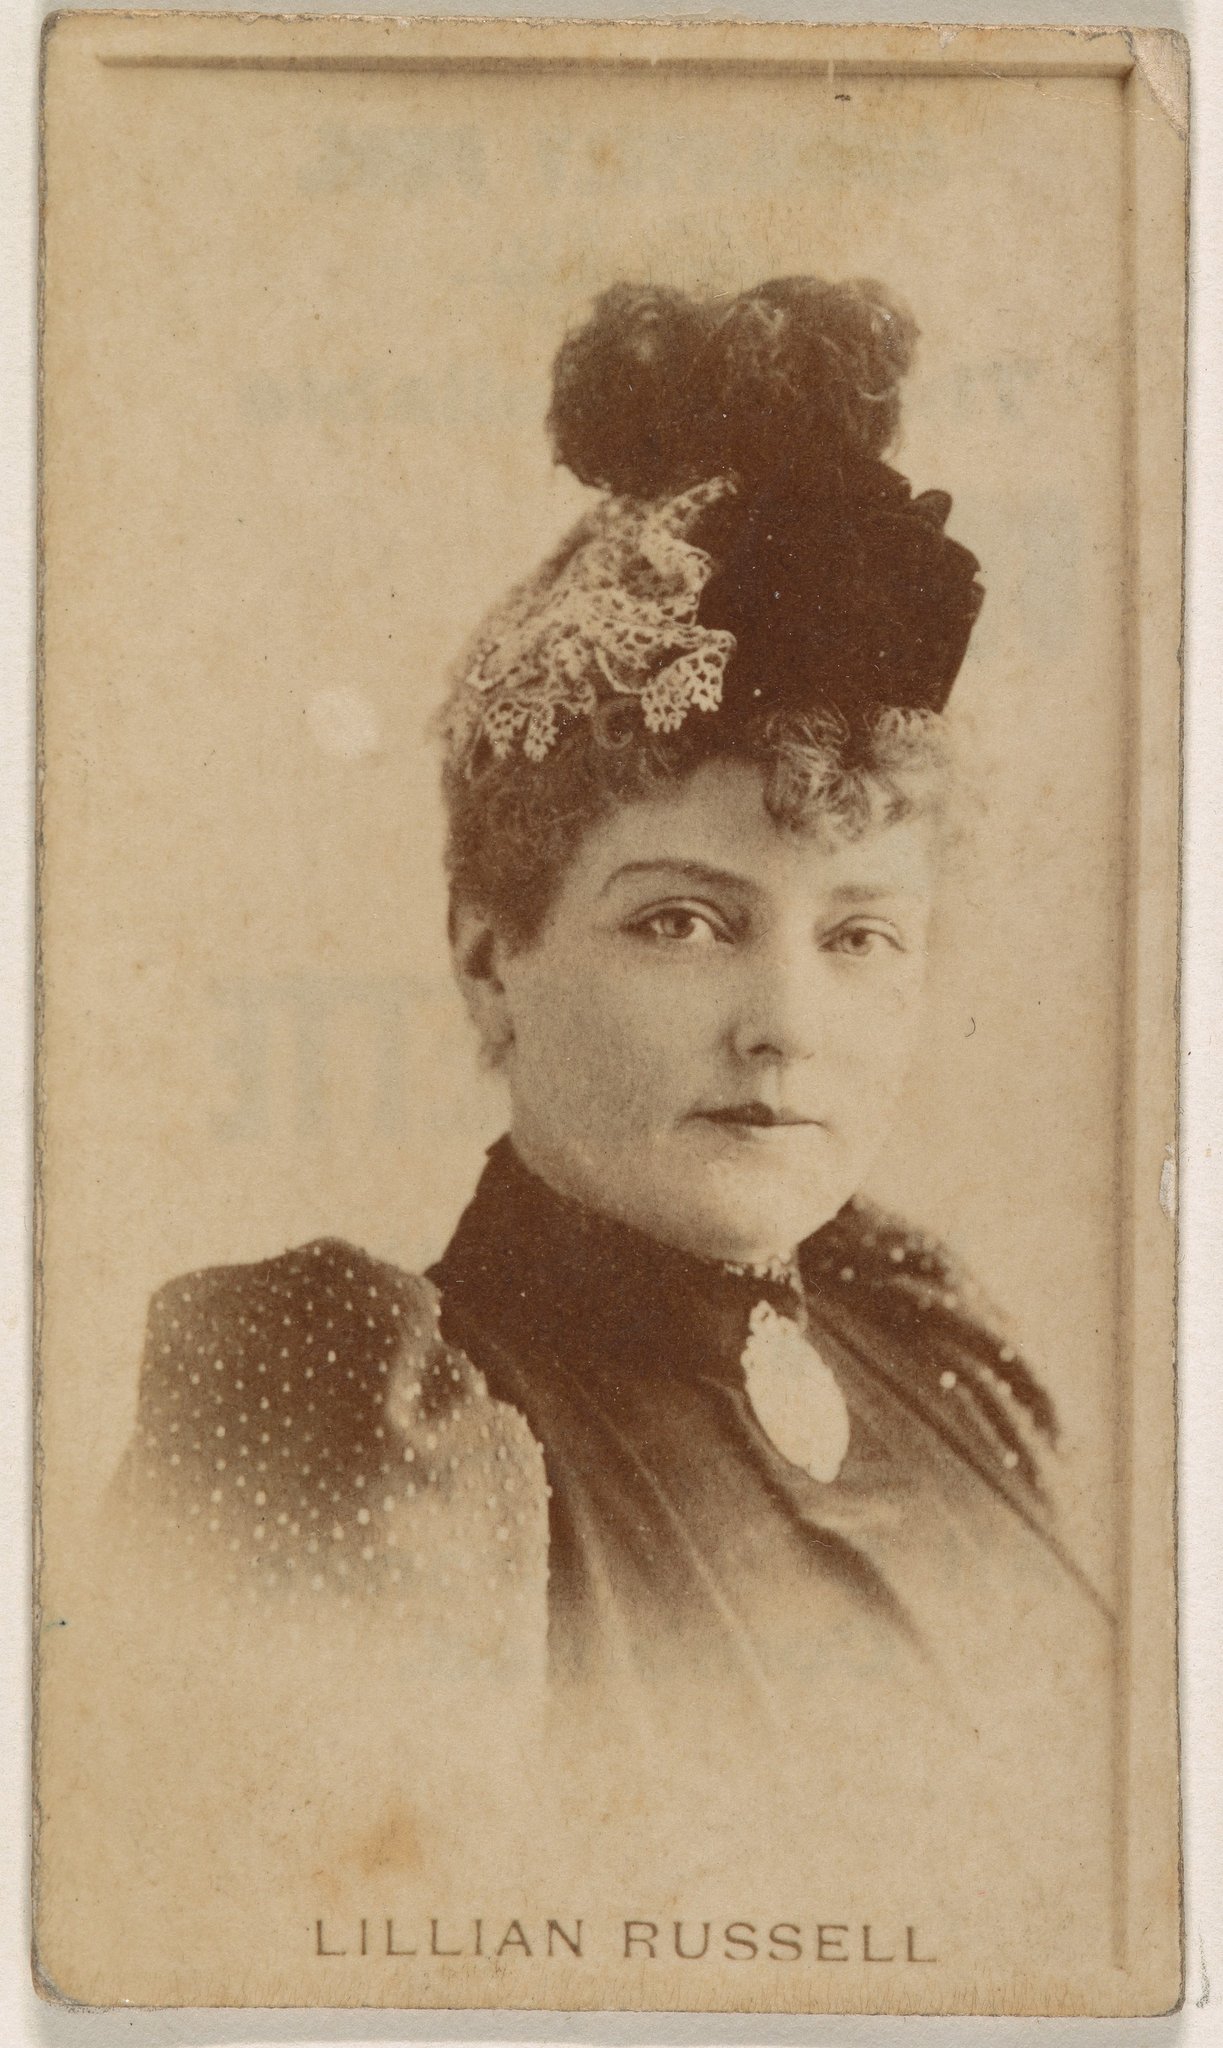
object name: photograph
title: Lillian Russell, from the Actresses series (N245) issued by Kinney Brothers to promote Sweet Caporal Cigarettes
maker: kinney brothers tobacco company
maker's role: publisher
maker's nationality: american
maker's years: 1869-2011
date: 1890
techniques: albumen silver print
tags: portraits,women,actresses